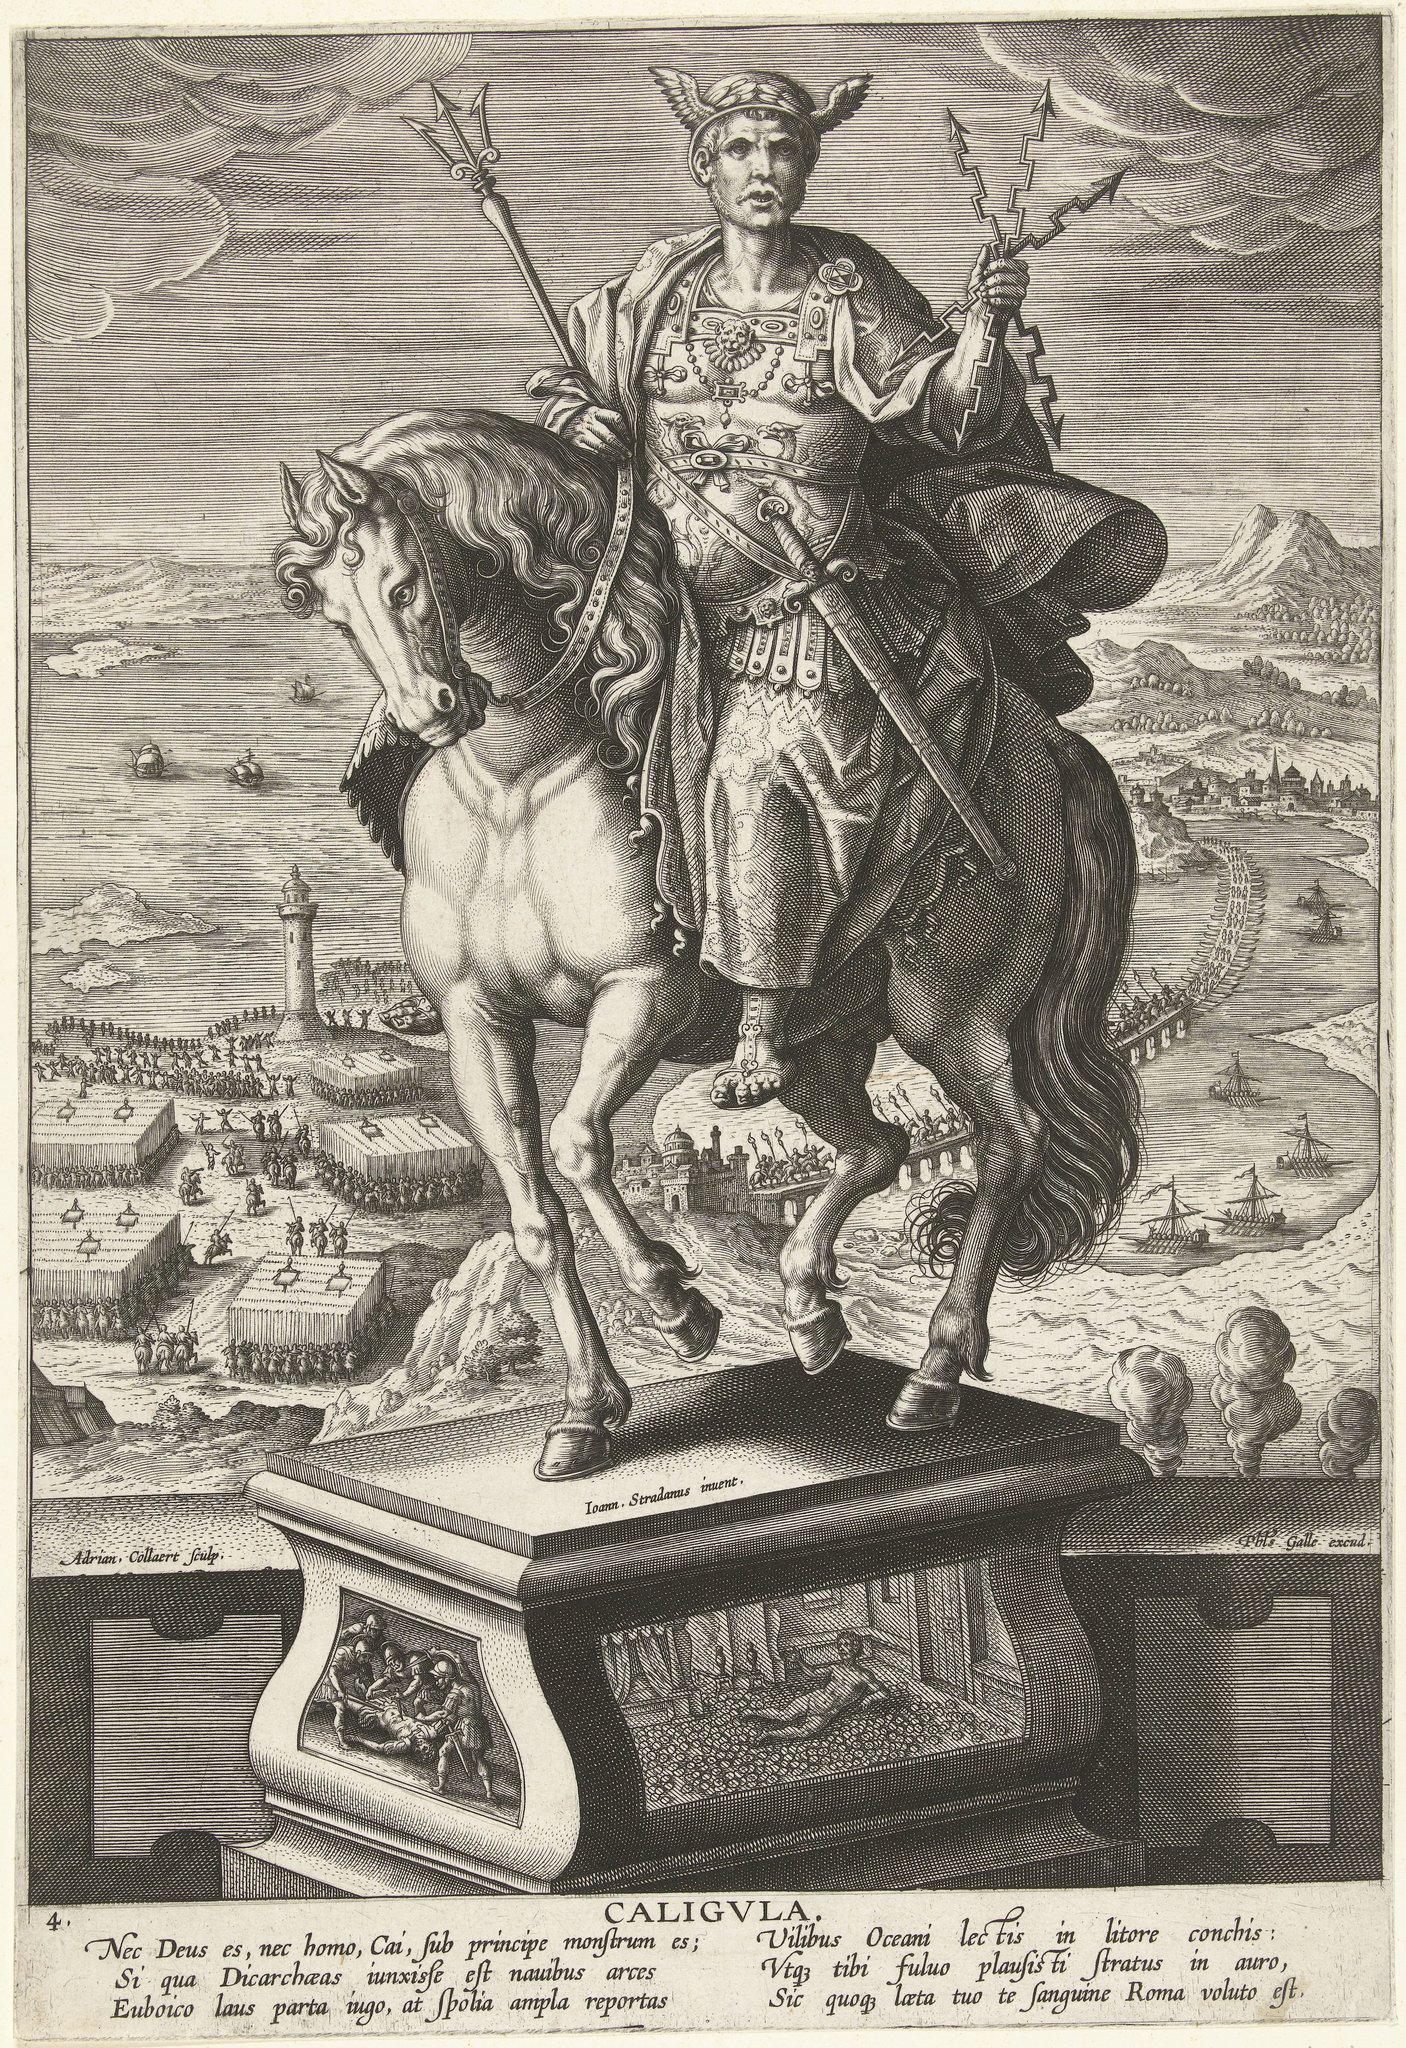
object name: print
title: Keizer Caligula te paard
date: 1587-1589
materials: paper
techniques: engraving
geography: antwerp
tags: germany, rome, male persons from classical history (caligula)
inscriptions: collector's mark: Lugt 2760, collector's mark: Lugt 2228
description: Op een kolom keizer Caligula te paard. Op de achtergrond scènes uit zijn leven. Links beveelt hij een leger schelpen te zoeken, rechts worden in opdracht van Caligula schepen gebruikt als brug. Onderaan de kolom in een cartouche de moord op Caligula door soldaten van de Praetoriaanse garde. In een andere cartouche wordt het waanzinnig gedrag van de keizer getoond: Caligula ligt naakt op een berg gouden munten. De prent heeft een Latijns onderschrift. De prent is deel van een twaalfdelige serie over Romeinse keizers.